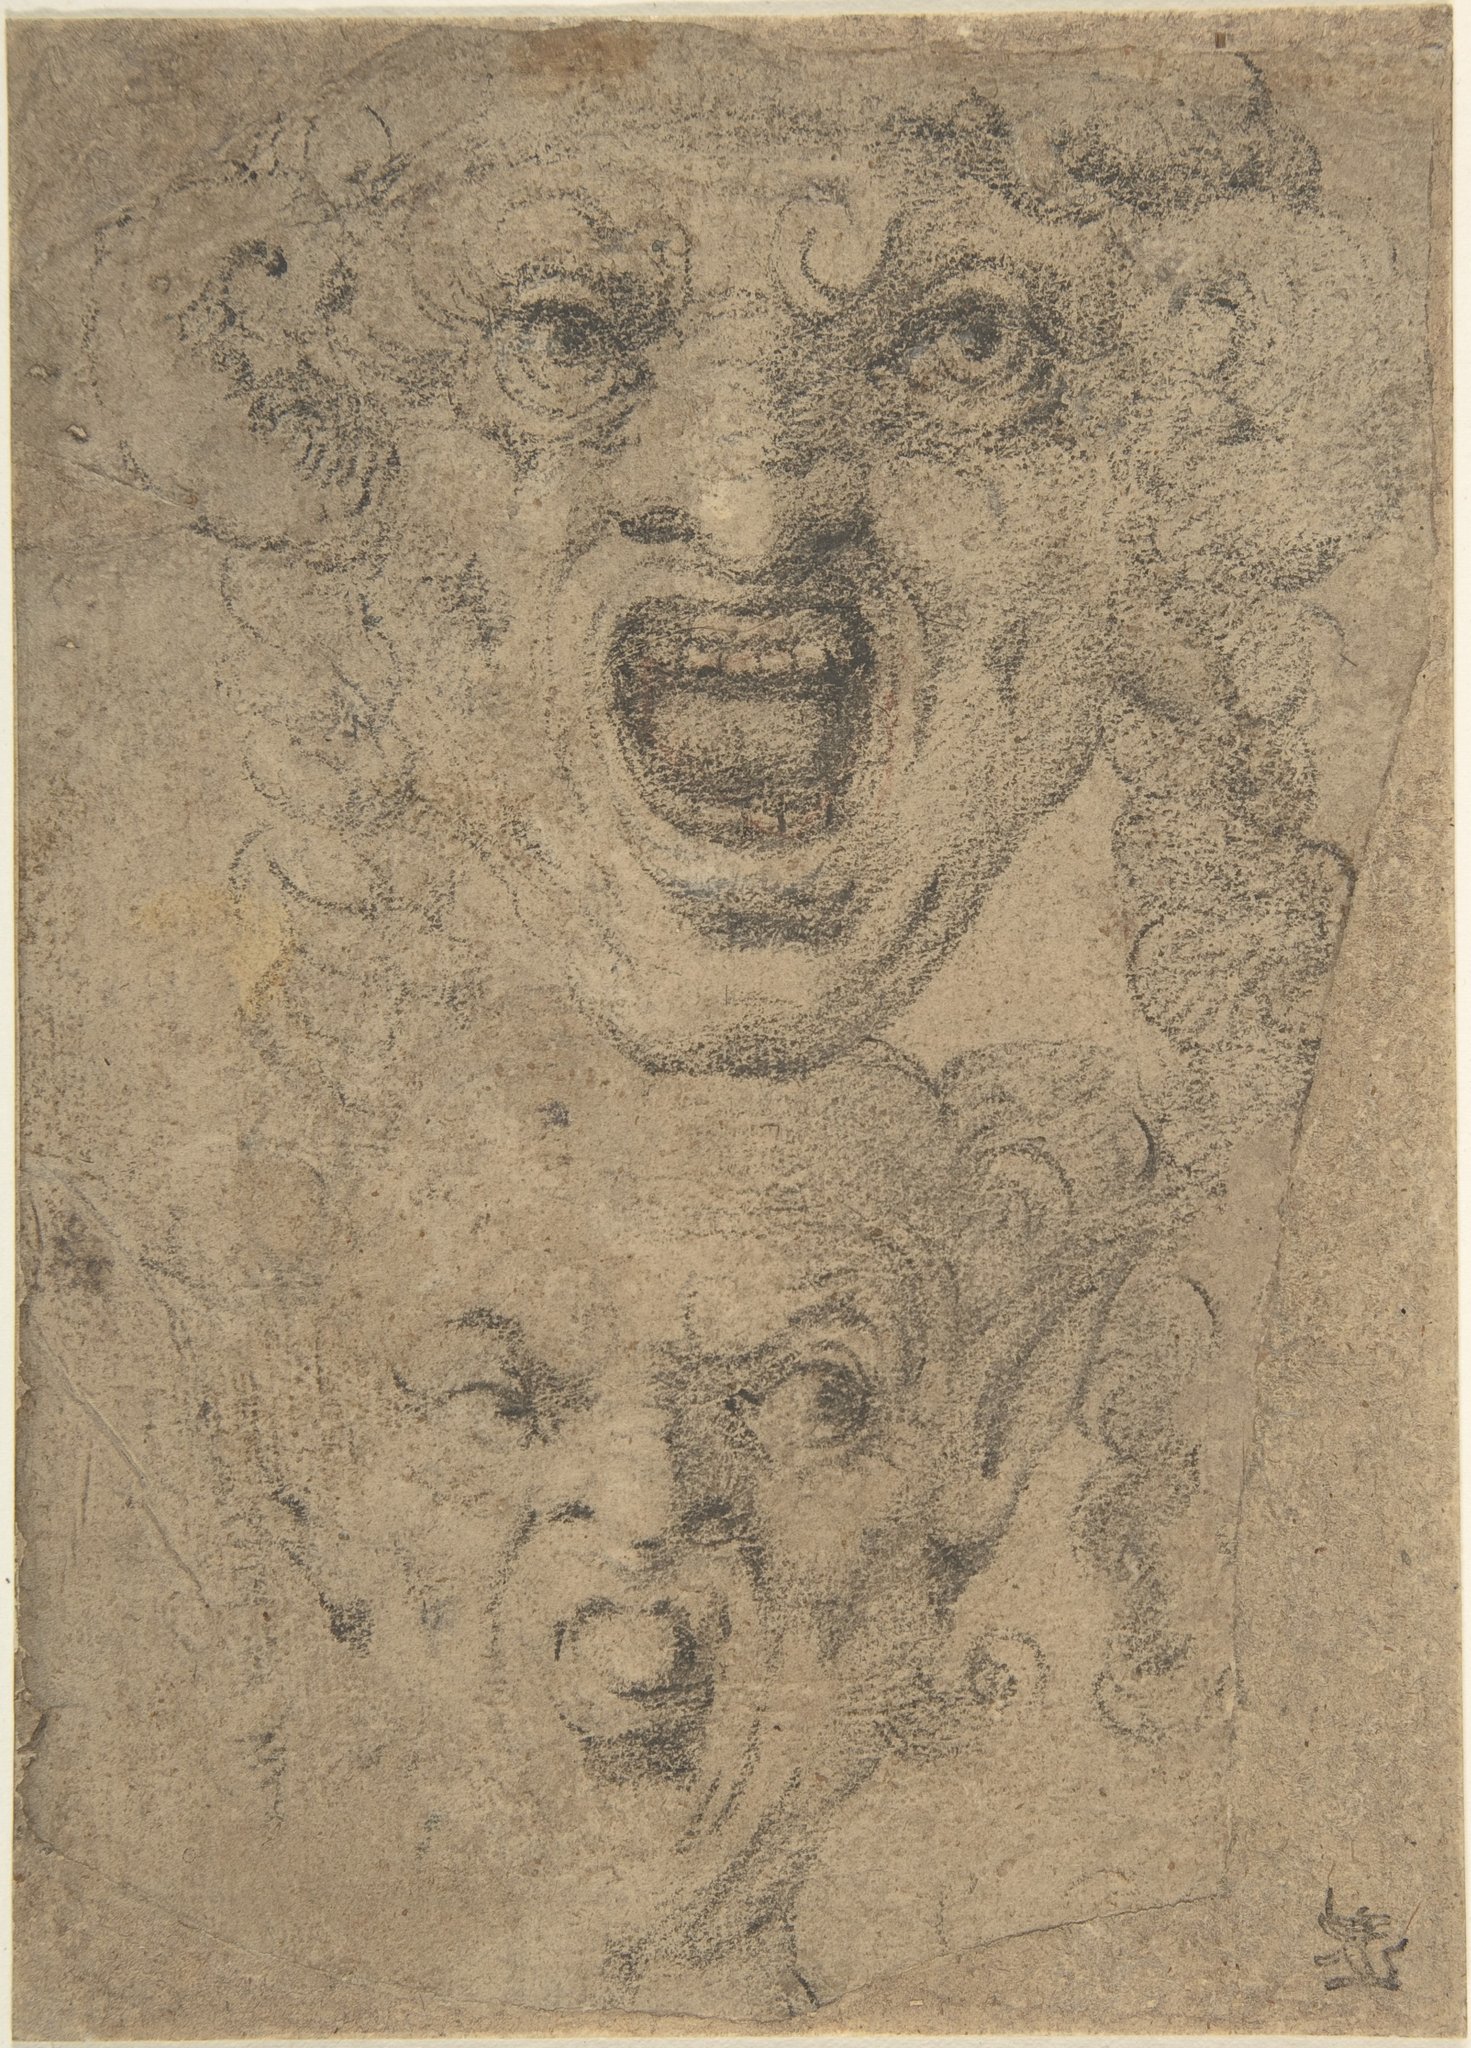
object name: drawing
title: Two Studies for a Grotesque Head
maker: anonymous, italian, 16th to 17th century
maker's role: artist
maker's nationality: italian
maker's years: 1500-1700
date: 1501-1700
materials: chalk, graphite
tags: heads